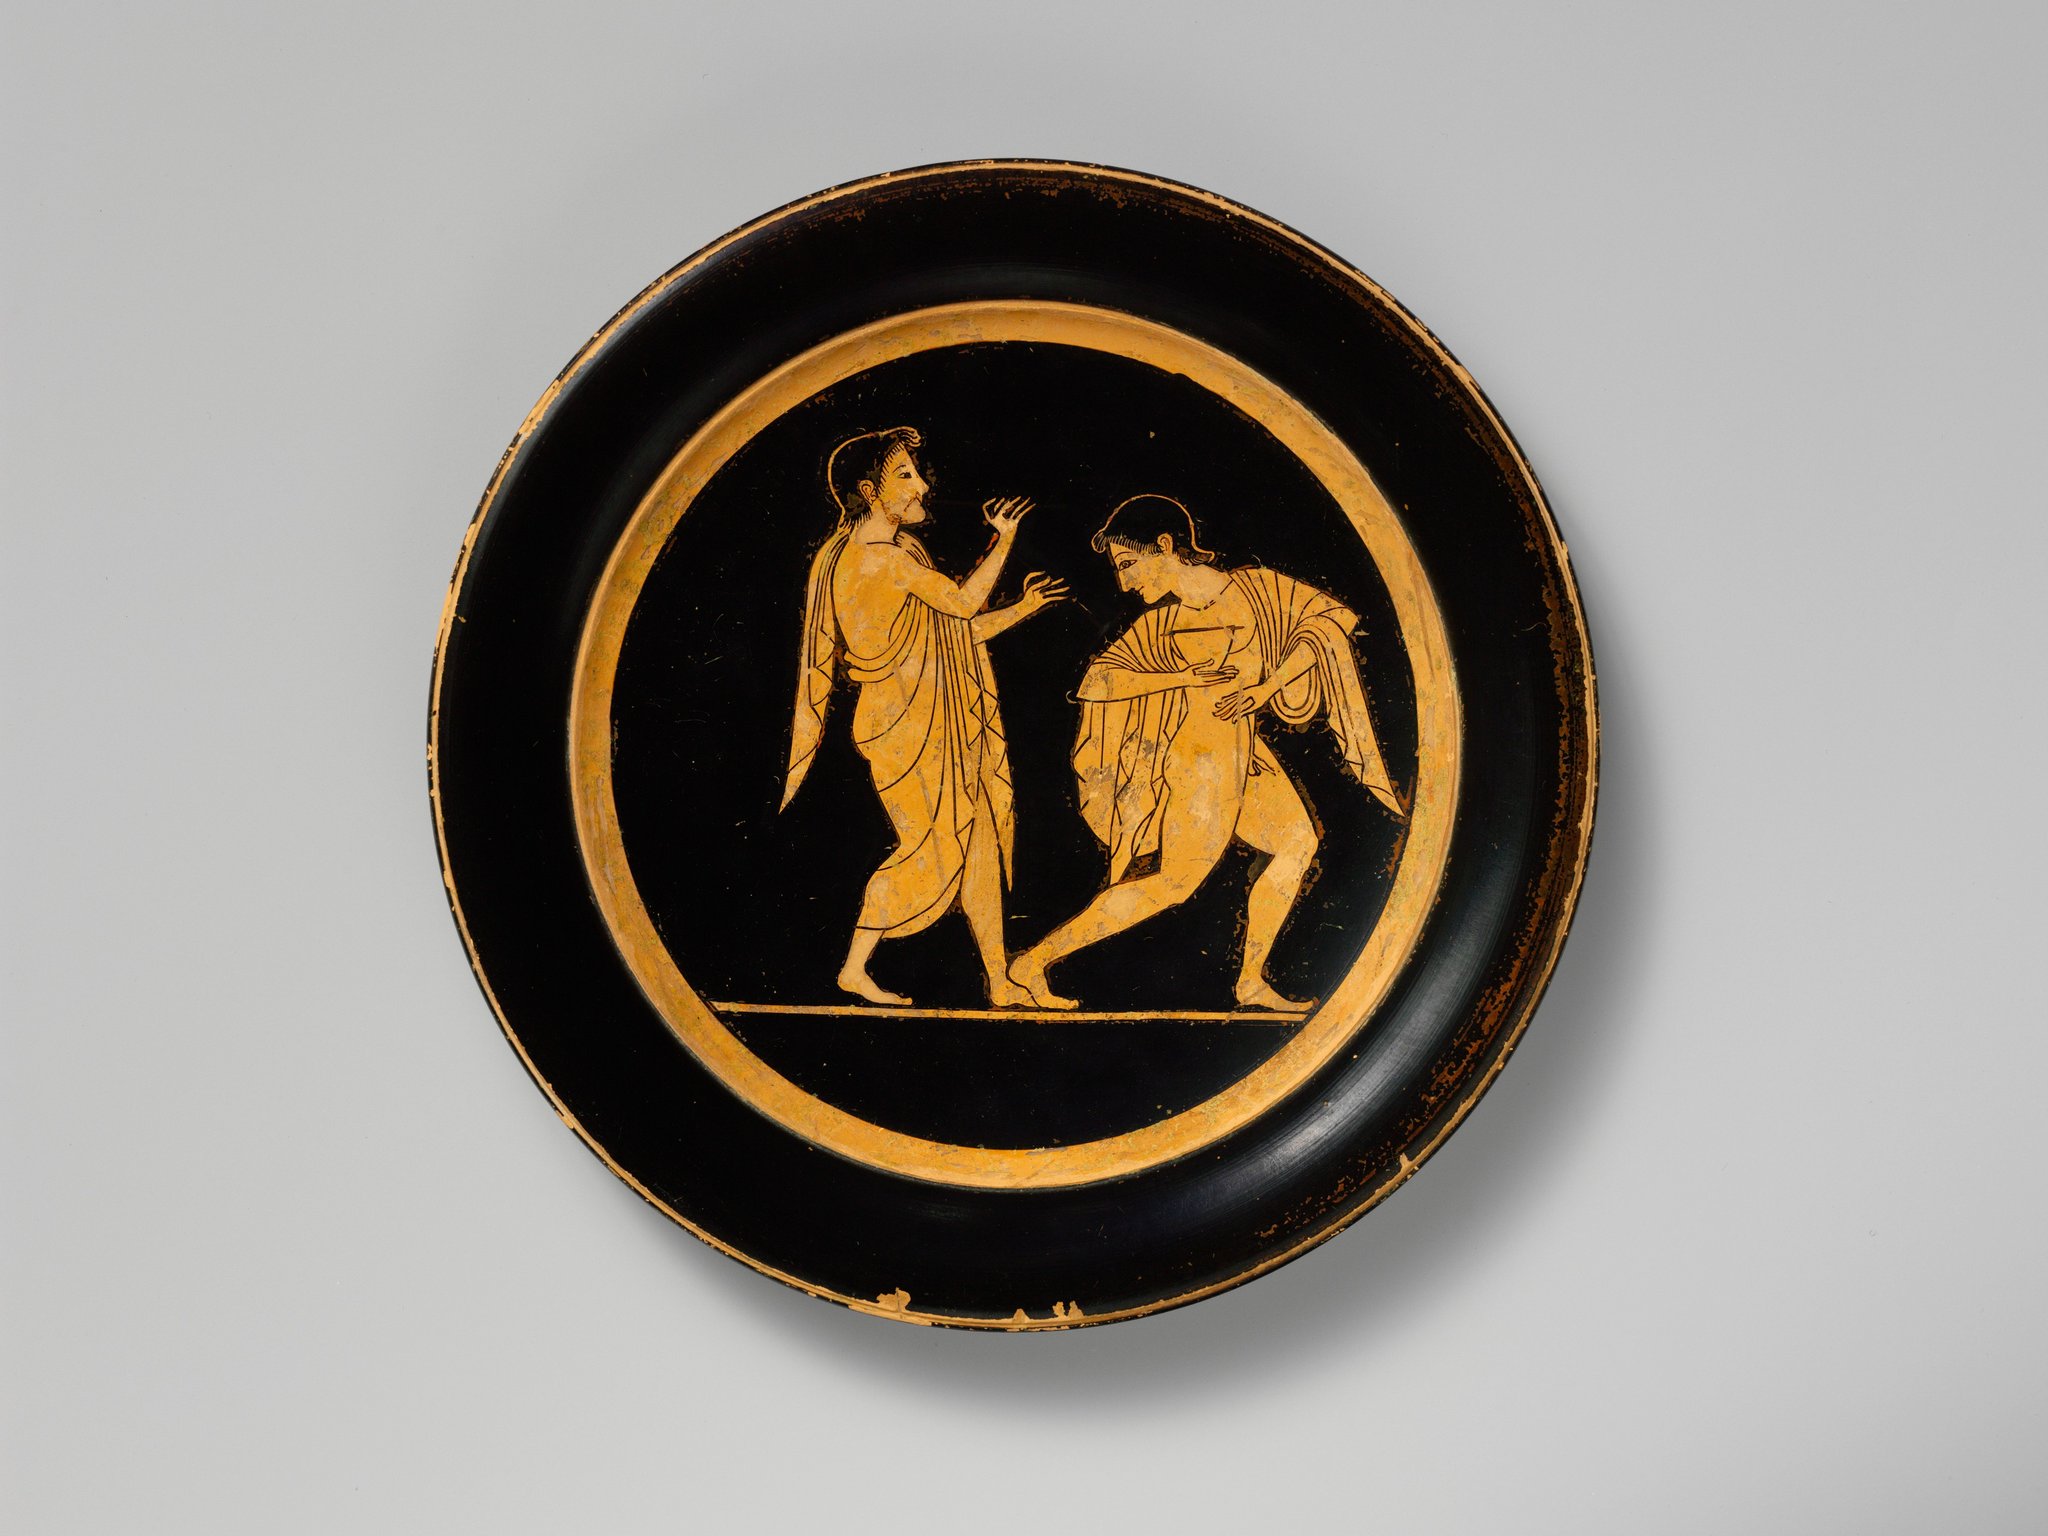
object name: plate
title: Terracotta plate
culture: greek, attic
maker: paseas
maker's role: artist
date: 510 BCE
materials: terracotta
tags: men,male nudes